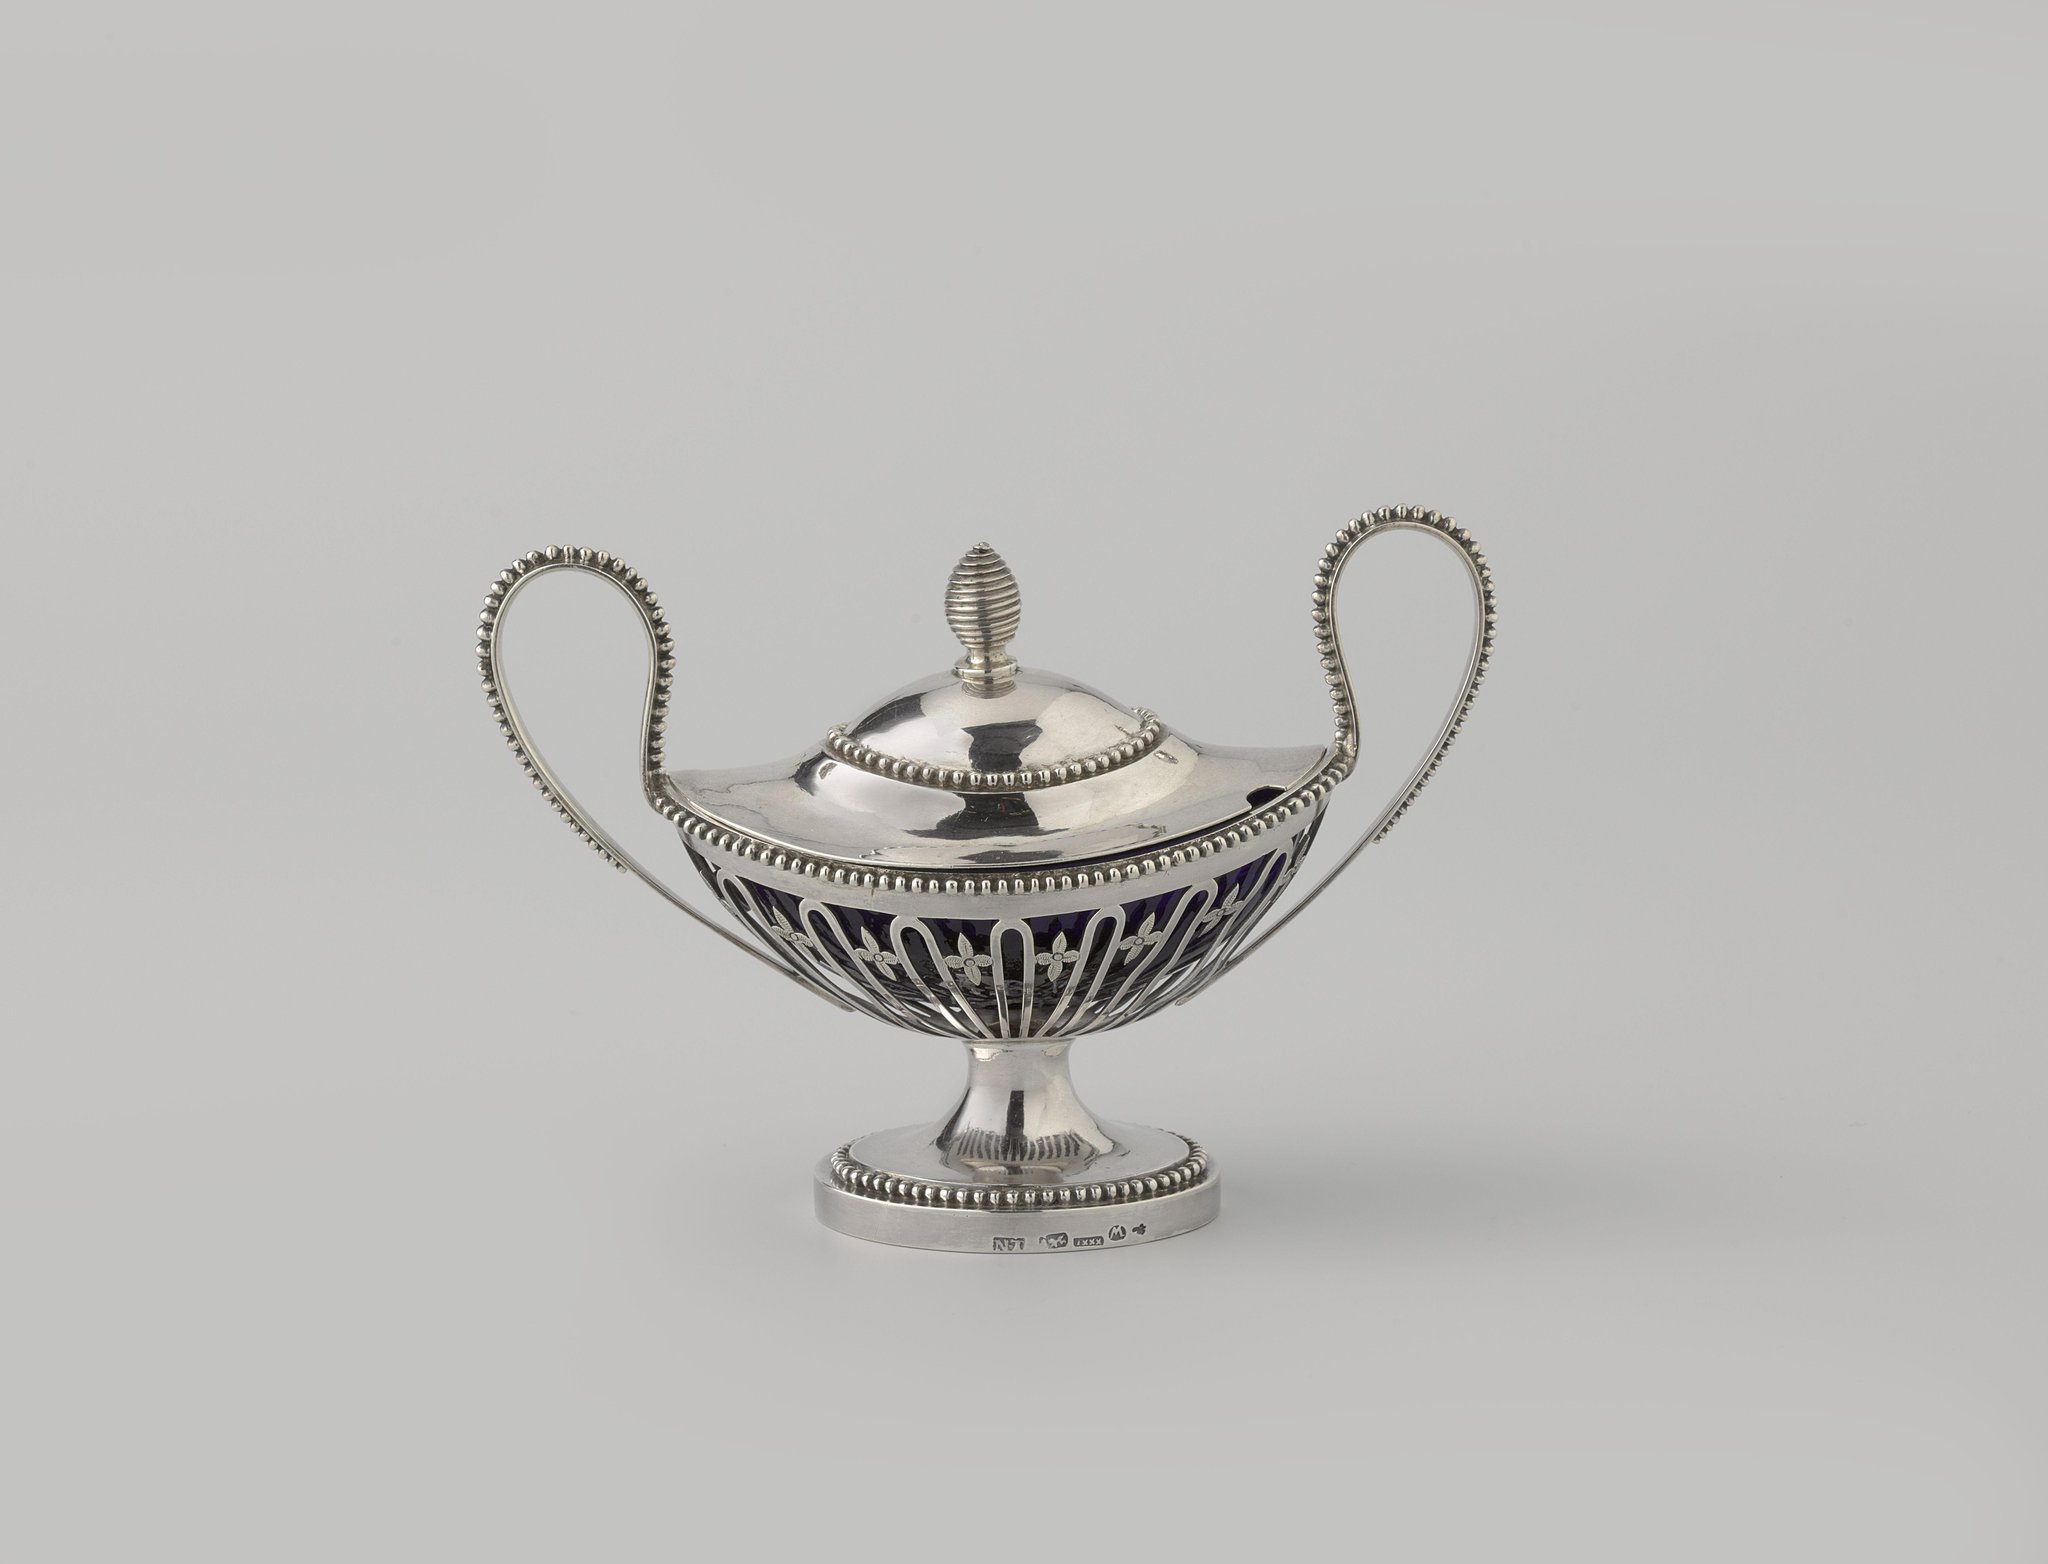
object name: mustard pot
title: Mosterdpot, spitsovaal, met opengewerkte wand met parellijsten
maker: nathanael teuter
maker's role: silversmith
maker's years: 1767-1831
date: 1805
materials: glass, silver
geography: amsterdam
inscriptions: maker's mark, duty mark, date letter: ‘W’, alloy mark, town mark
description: De vier spits ovale, gewelfde vaten (A, B,C en D), die aan de zijkanten iets verhoogde wanden hebben, rusten elk op een ovale, zich naar boven sterk verjongende voet op een rechtwandige basis. Op het met afwisselend knerren en rozetten opengewerkte lichaam past een scharnierend, gewelfd deksel dat wordt bekroond door een geribde pijnappelvormige knop. Rond de voet, rond de bovenrand van het lichaam, over de hoog oplopende, gebogen oren en rond het deksel lopen parellijsten. In de potten passen binnenbakjes van blauw glas.